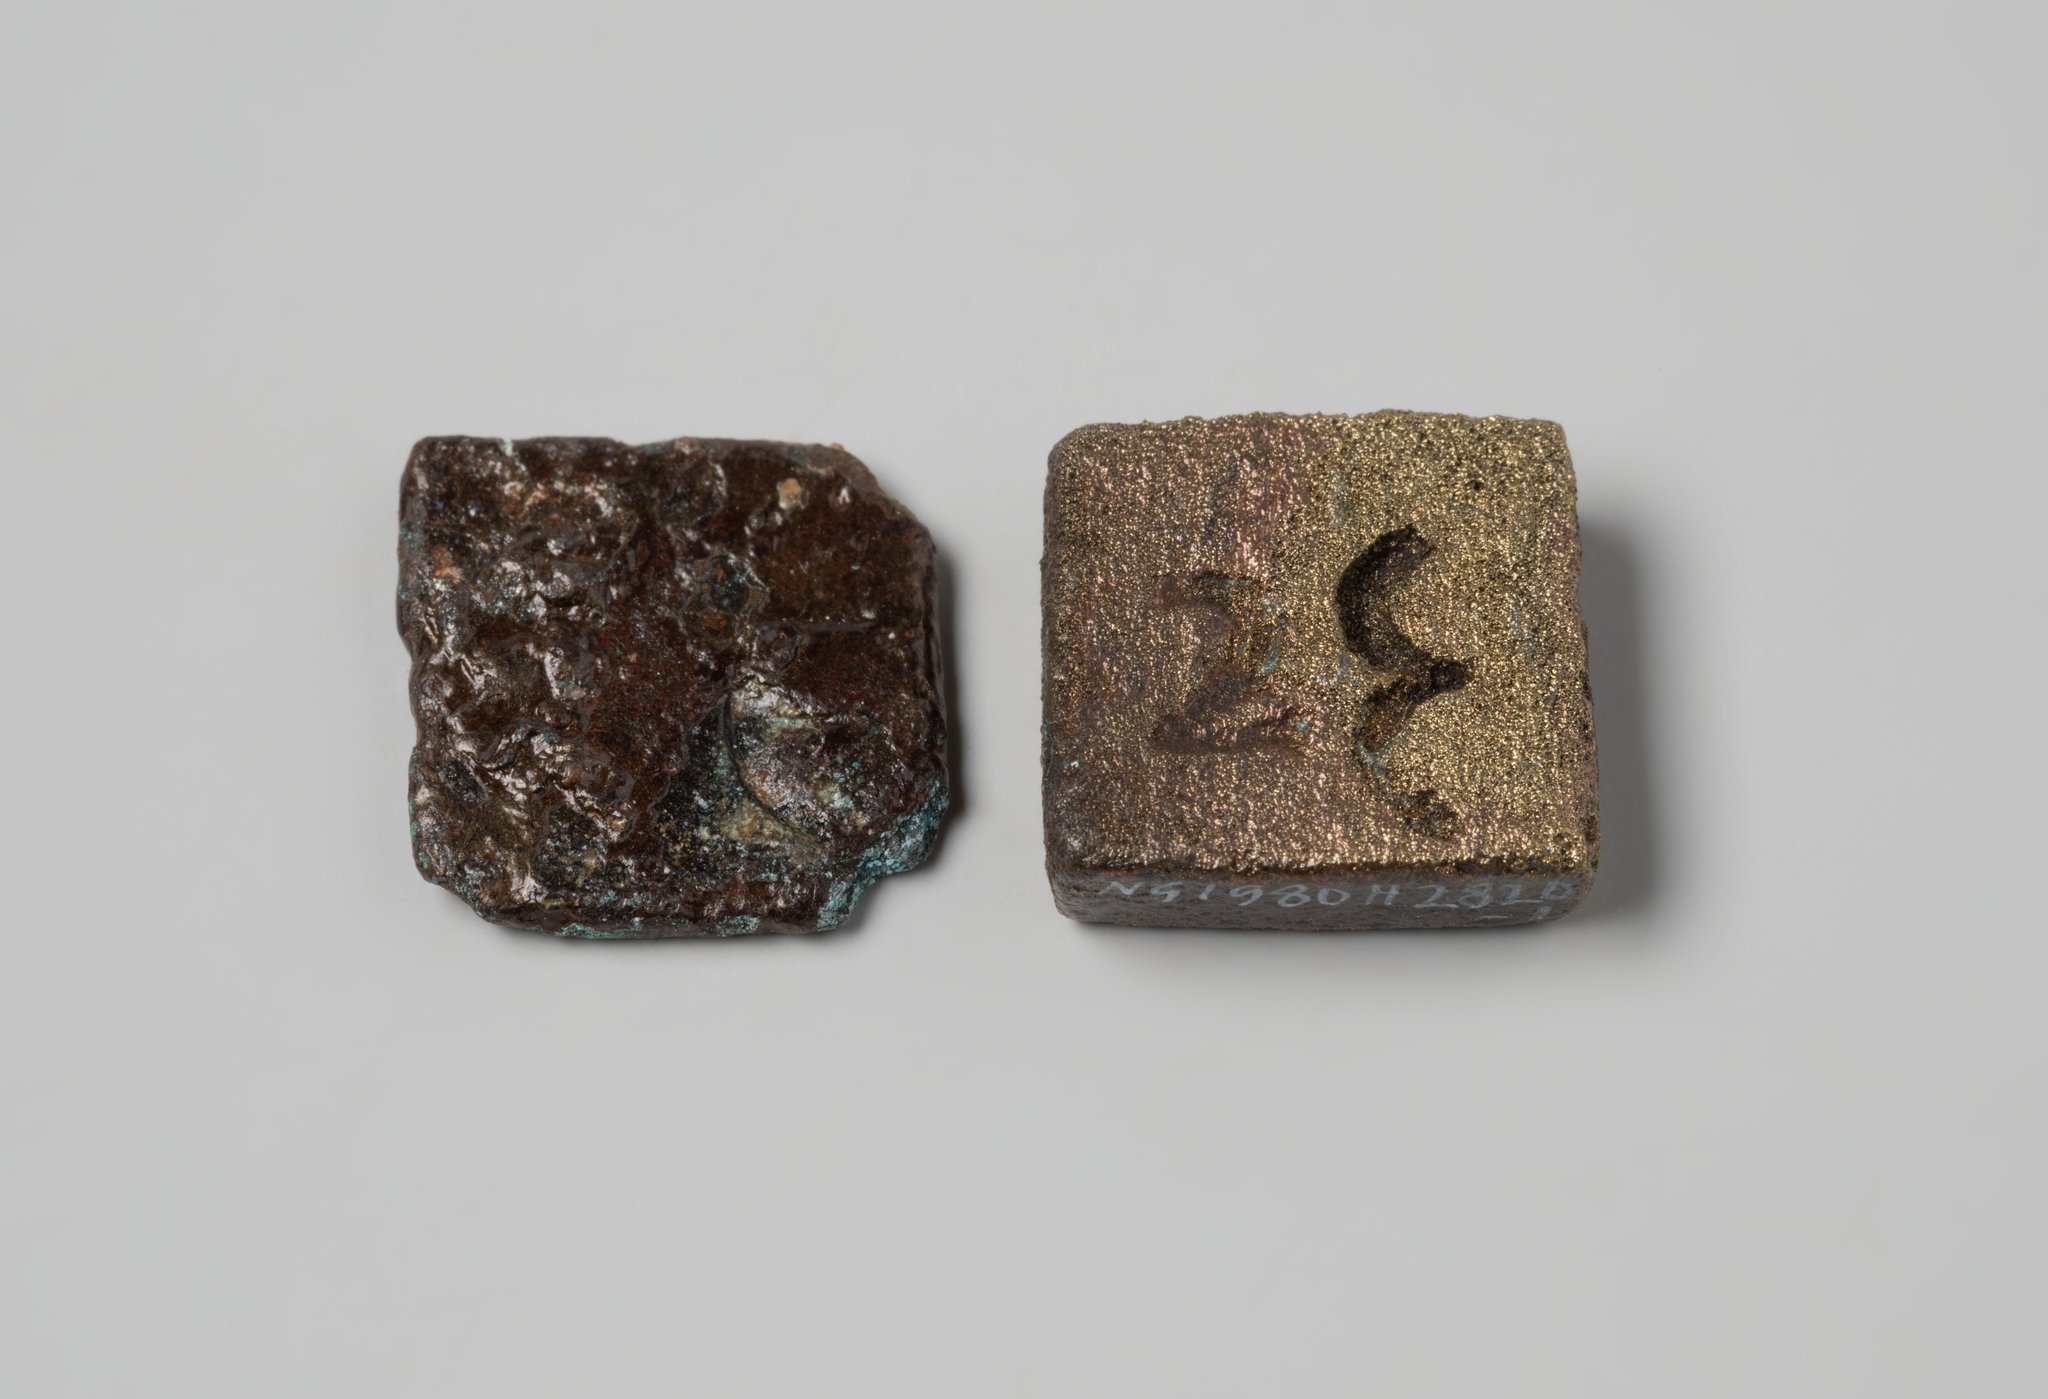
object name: weighing device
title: Gewichten apothekersbalans uit het wrak van de Oost-Indiëvaarder Hollandia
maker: Anonymous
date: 1700-1743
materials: copper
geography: netherlands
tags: verenigde oostindische compagnie, hollandia (schip), annet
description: Tools and instruments, medical, apothecaries' weight; drachms, eroded and scruples.